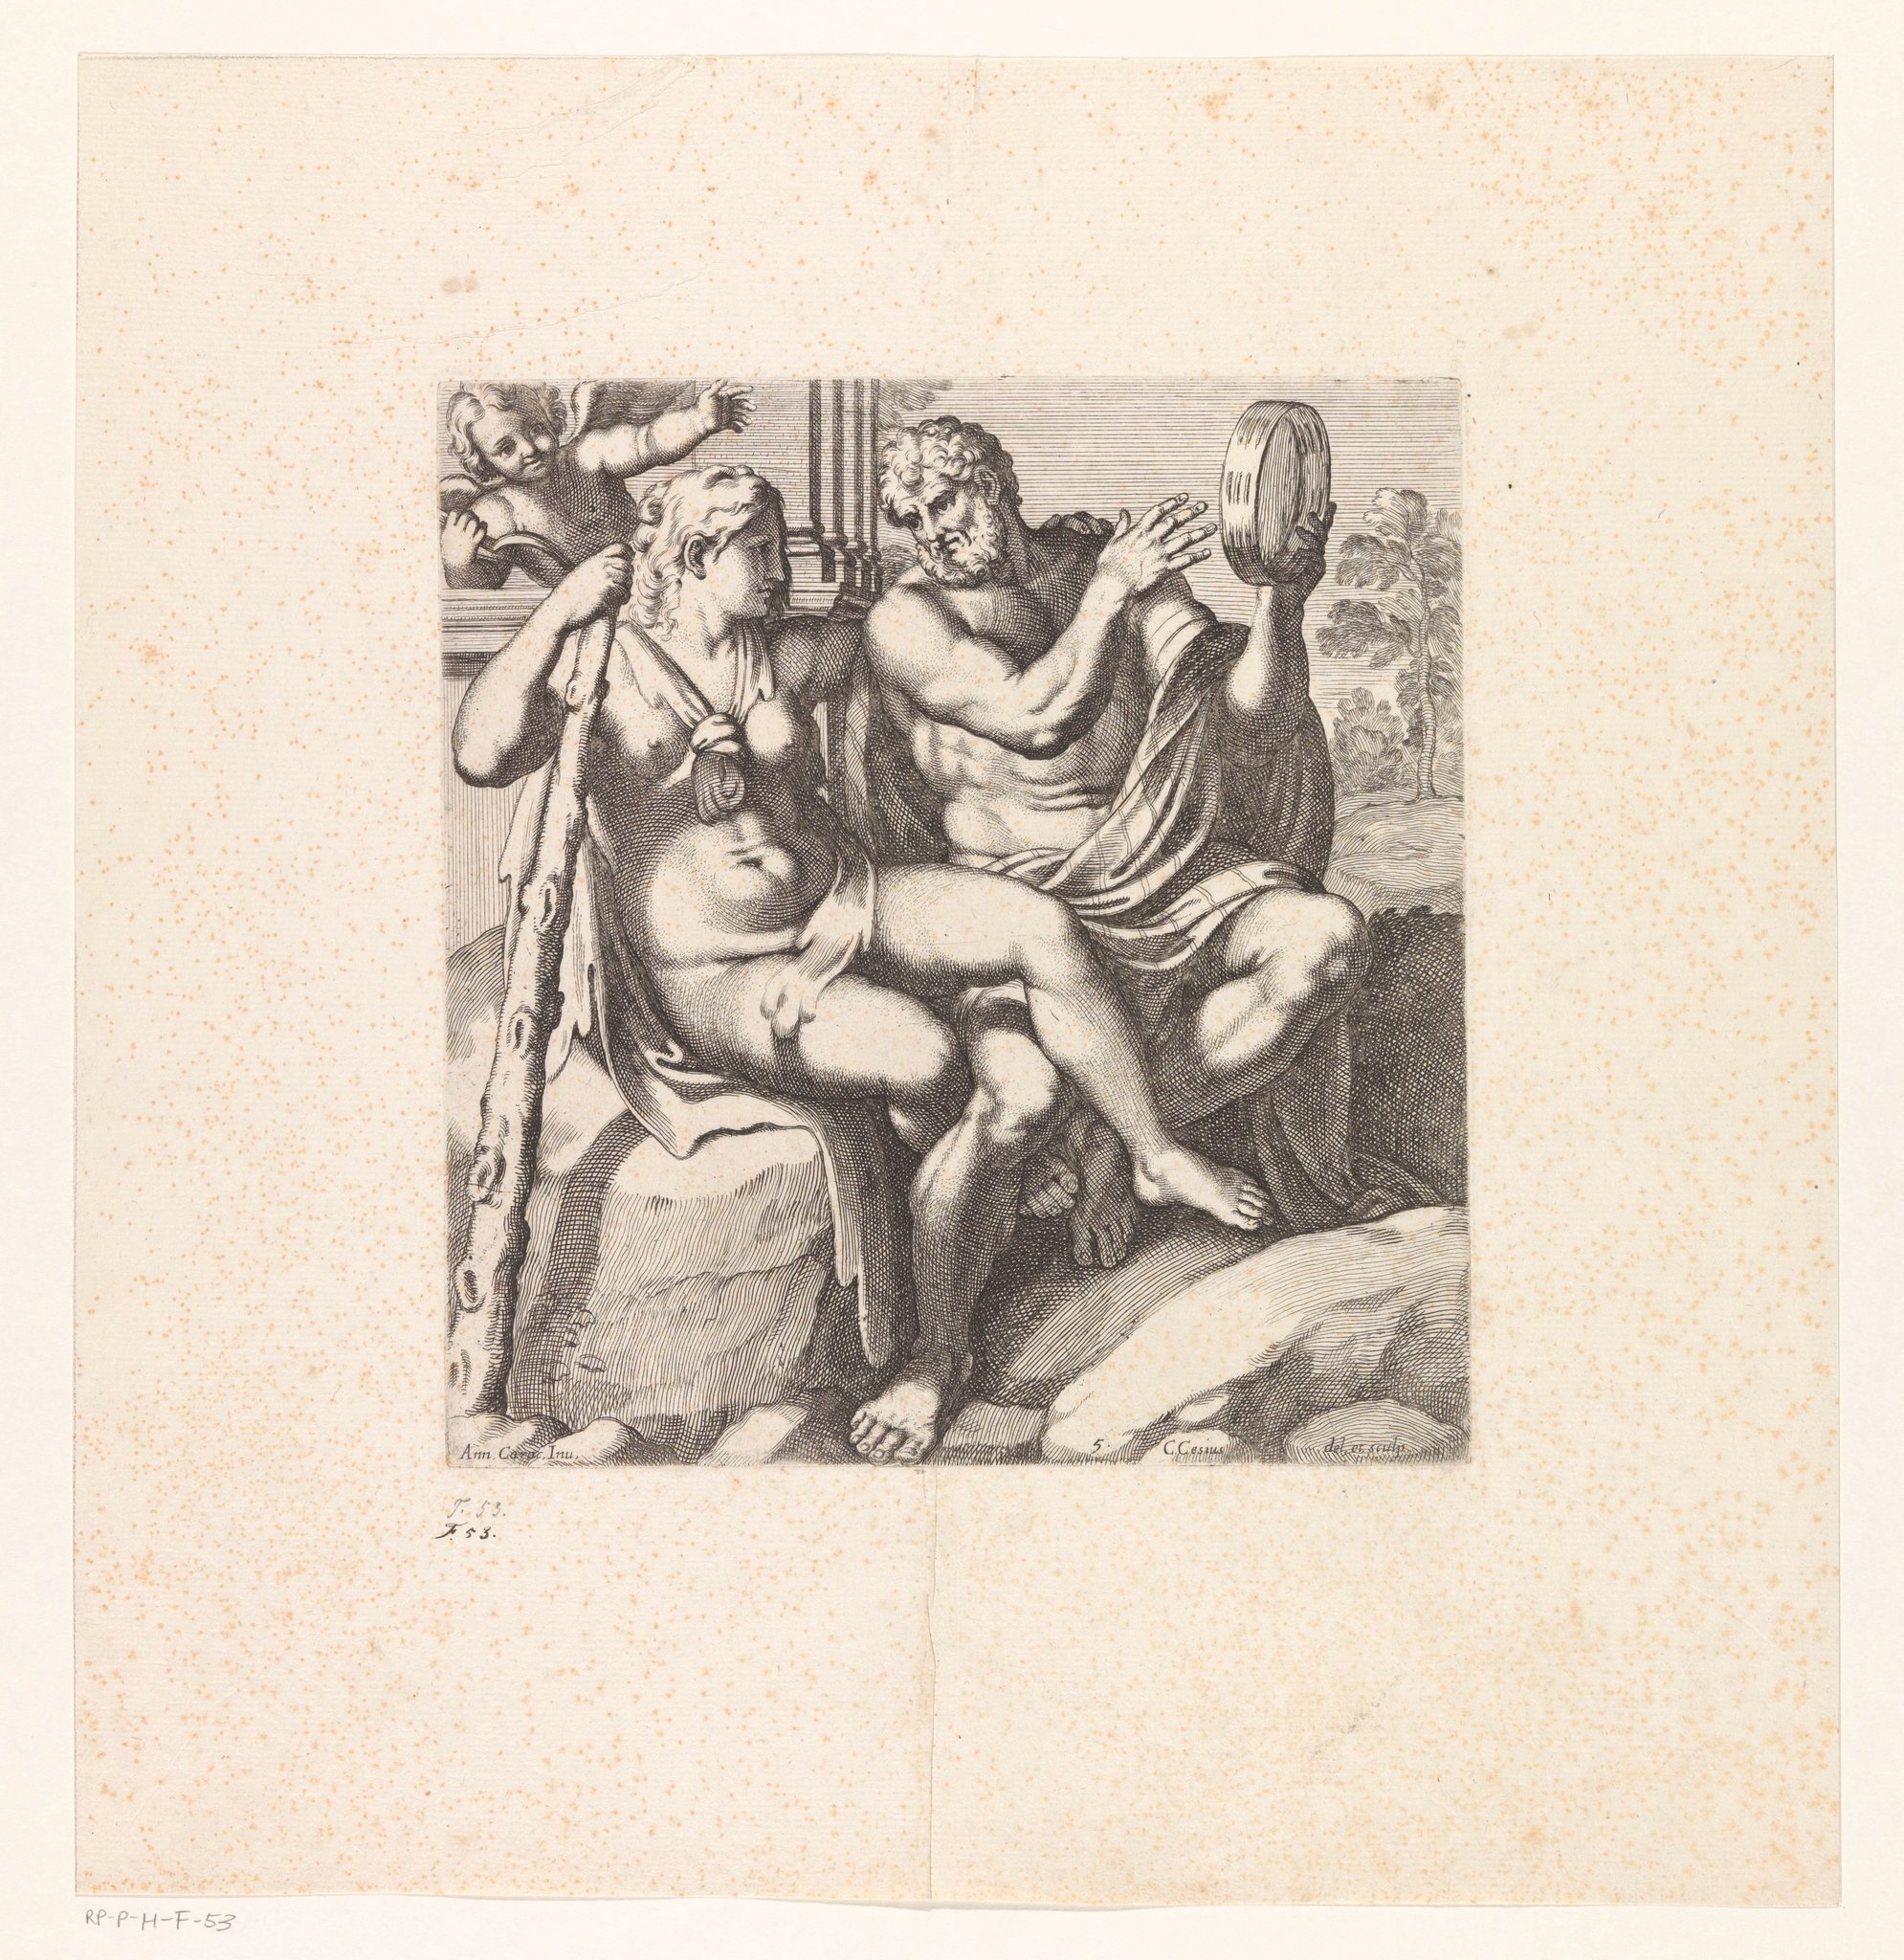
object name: print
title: Hercules en Iole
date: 1656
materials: paper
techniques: etching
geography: rome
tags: hercules wooing iole, (story of) cupid, amor (eros)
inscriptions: collector's mark: ‘Hinloopen’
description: Prent uit een reeks prenten met nummers van 1 tot en met 29 (sommige prenten hebben hetzelfde nummer), plus titelprent en opdracht, naar schilderingen in Palazzo Farnese te Rome. Deze prent maakte oorspronkelijk deel uit van liber nr. 22 van de Atlas van Rome, uit de collectie Hinloopen. In dit album waren een aantal prentreeksen naar bekende zeventiende eeuwse frescoseries bijeengebonden. In 1709 heeft Schijnvoet op last van de burgemeesters van Amsterdam de collectie herordend. De prenten uit liber 22 kwamen terrecht in Schijnvoet boek nr. 10. De laatst gedateerde reeks in het album is gedateerd 1691. Het album moet dus na deze datum gebonden zijn. De band is in de Rijksakademietijd uit elkaar gehaald. De marges van de prenten zijn bij het opbergen in het Rijksprentenkabinet vaak drastisch afgesneden. Van een aantal series waren de prenten teruggeslagen om in het album te passen. (Zie: Waals, Jan van der. De prentschat van Michiel Hinloopen. 's-Gravenhage: SDU uitgeverij, 1988, pp. 173-174.)